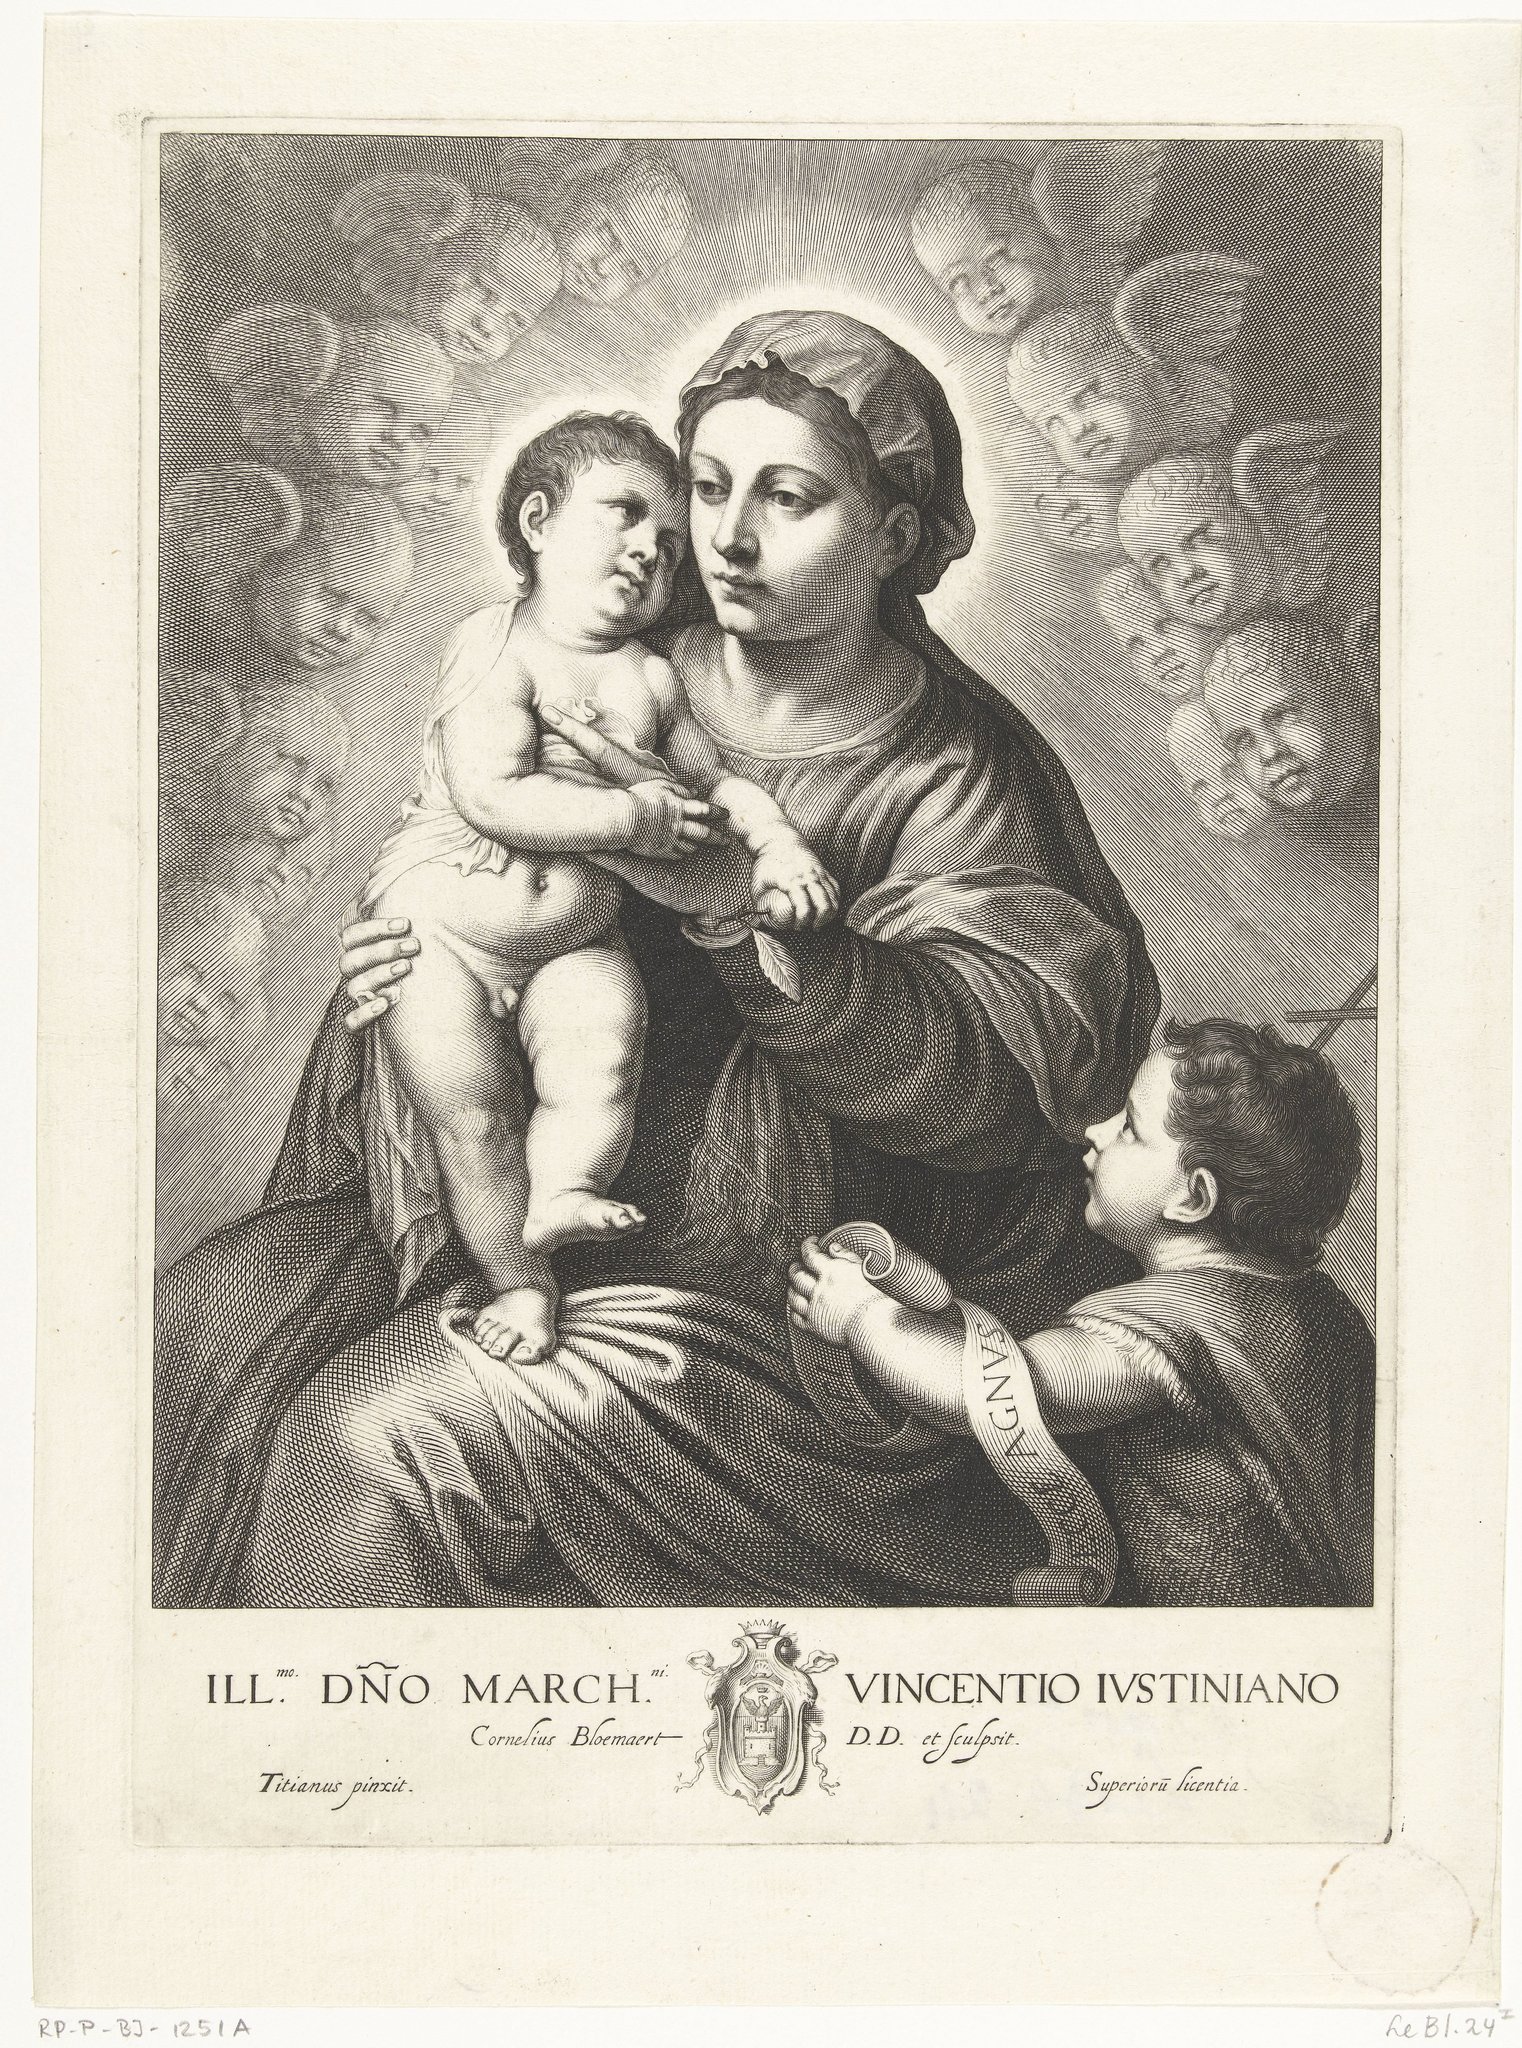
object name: print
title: Madonna en Johannes de Doper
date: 1633-1637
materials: paper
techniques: engraving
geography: rome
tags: madonna: mary sitting or enthroned, the christ-child in her lap (or in front of her bosom) (mary sometimes represented half-length), madonna (i.e. mary with the christ-child) accompanied or surrounded by others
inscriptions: collector's mark: Lugt 240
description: Een zittende Maria met Christus staande op haar schoot. Rechts kijkt Johannes de Doper naar hen op. Links en rechts omgeven zestien engelenhoofdjes het drietal.